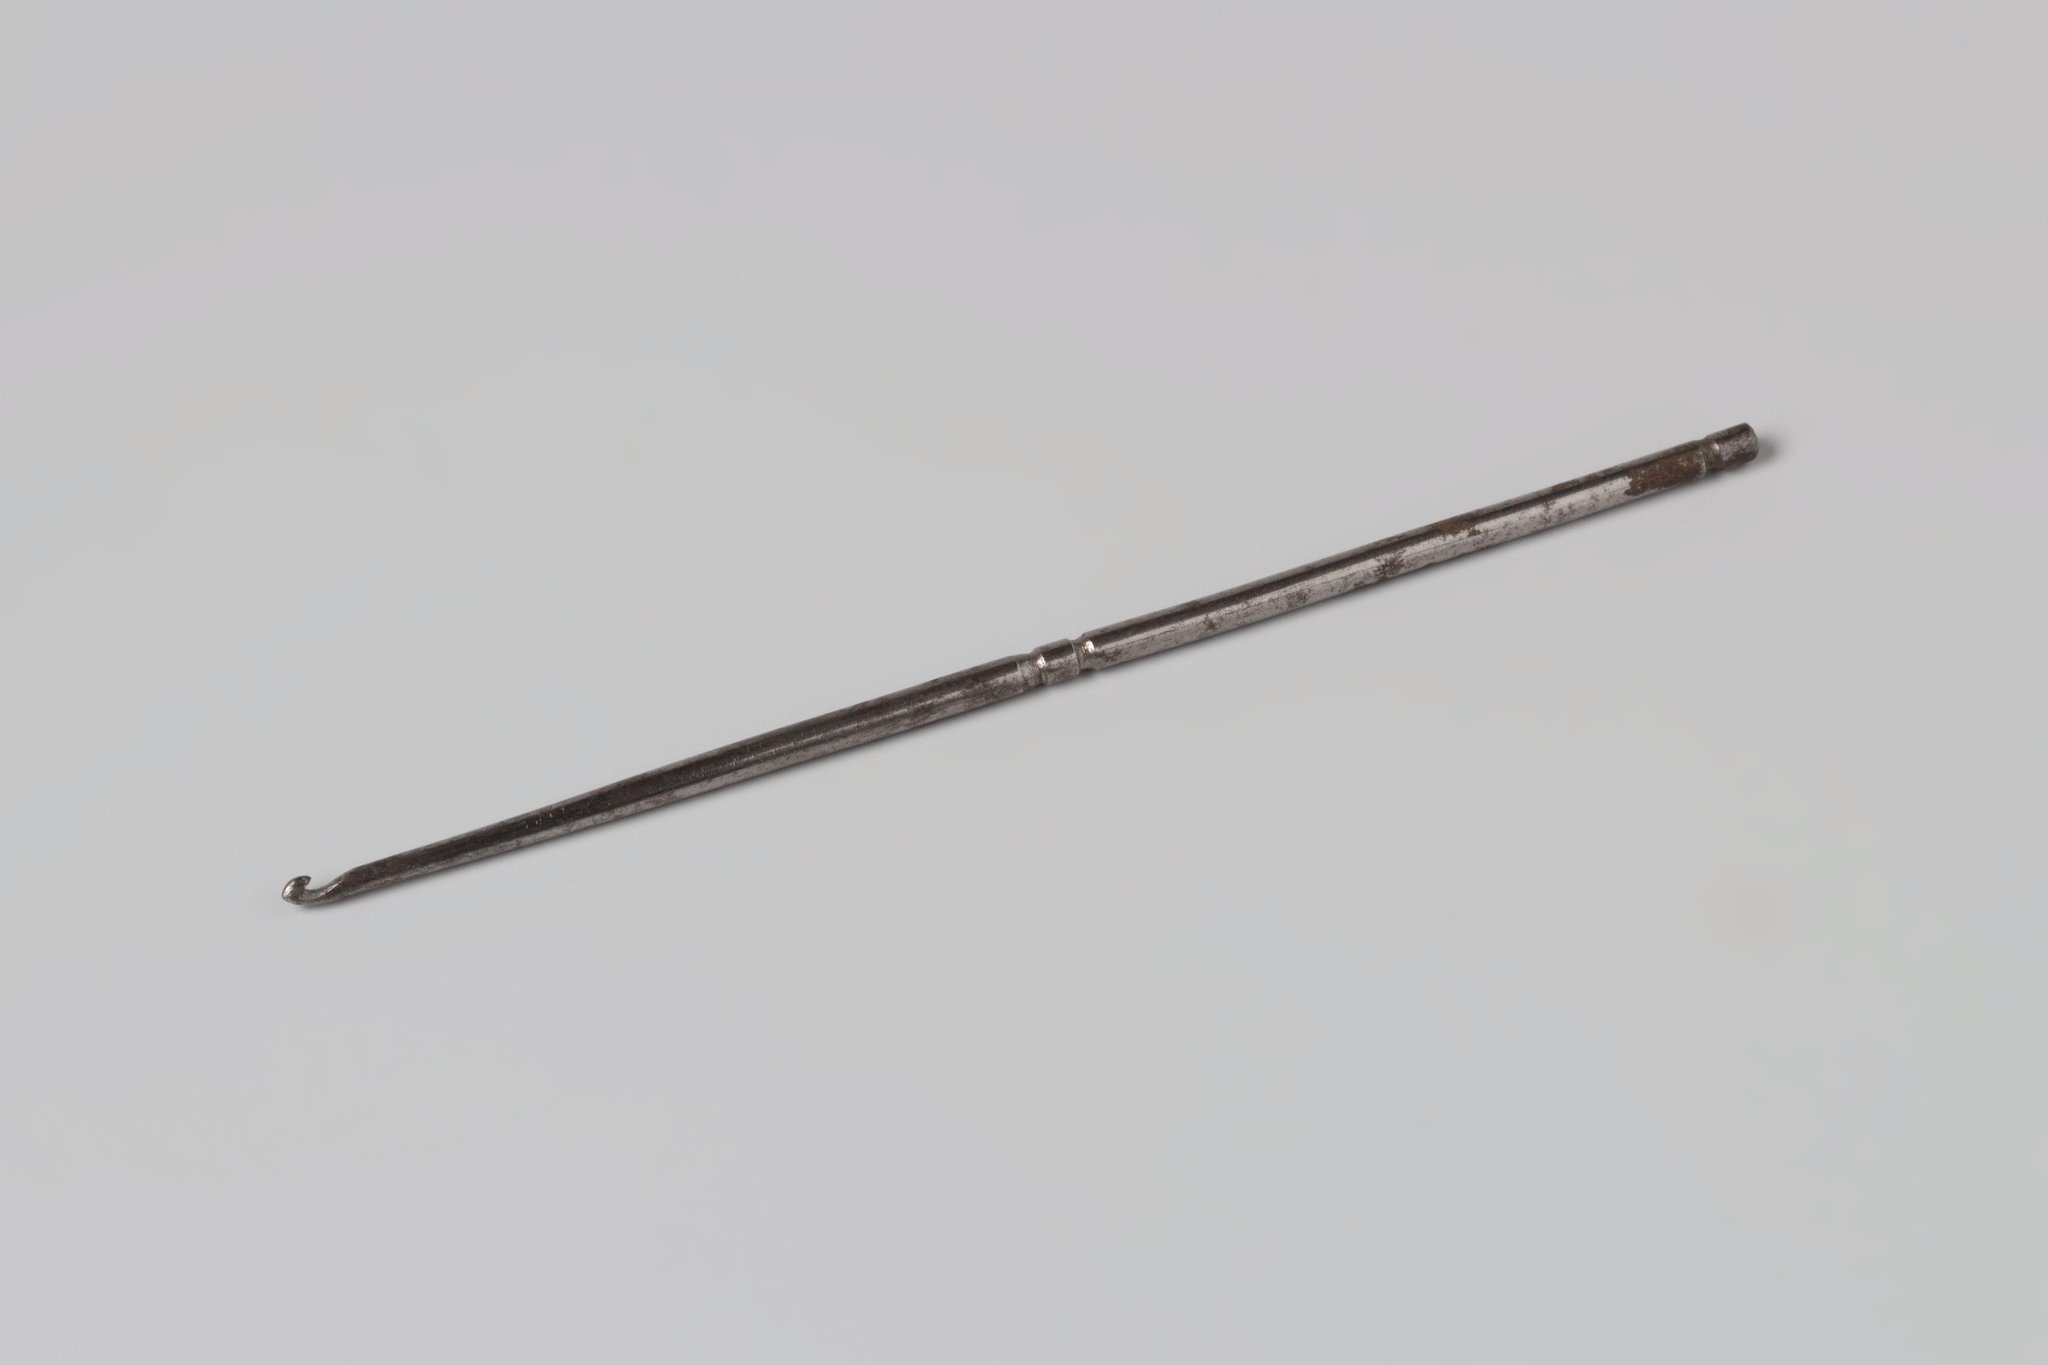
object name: textile working equipment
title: Haakpen van staal met knop en geleding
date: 1900-1950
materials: steel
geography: germany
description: Een haakpen van staal met knop en geleding. Adres: Imra / Geschützt.